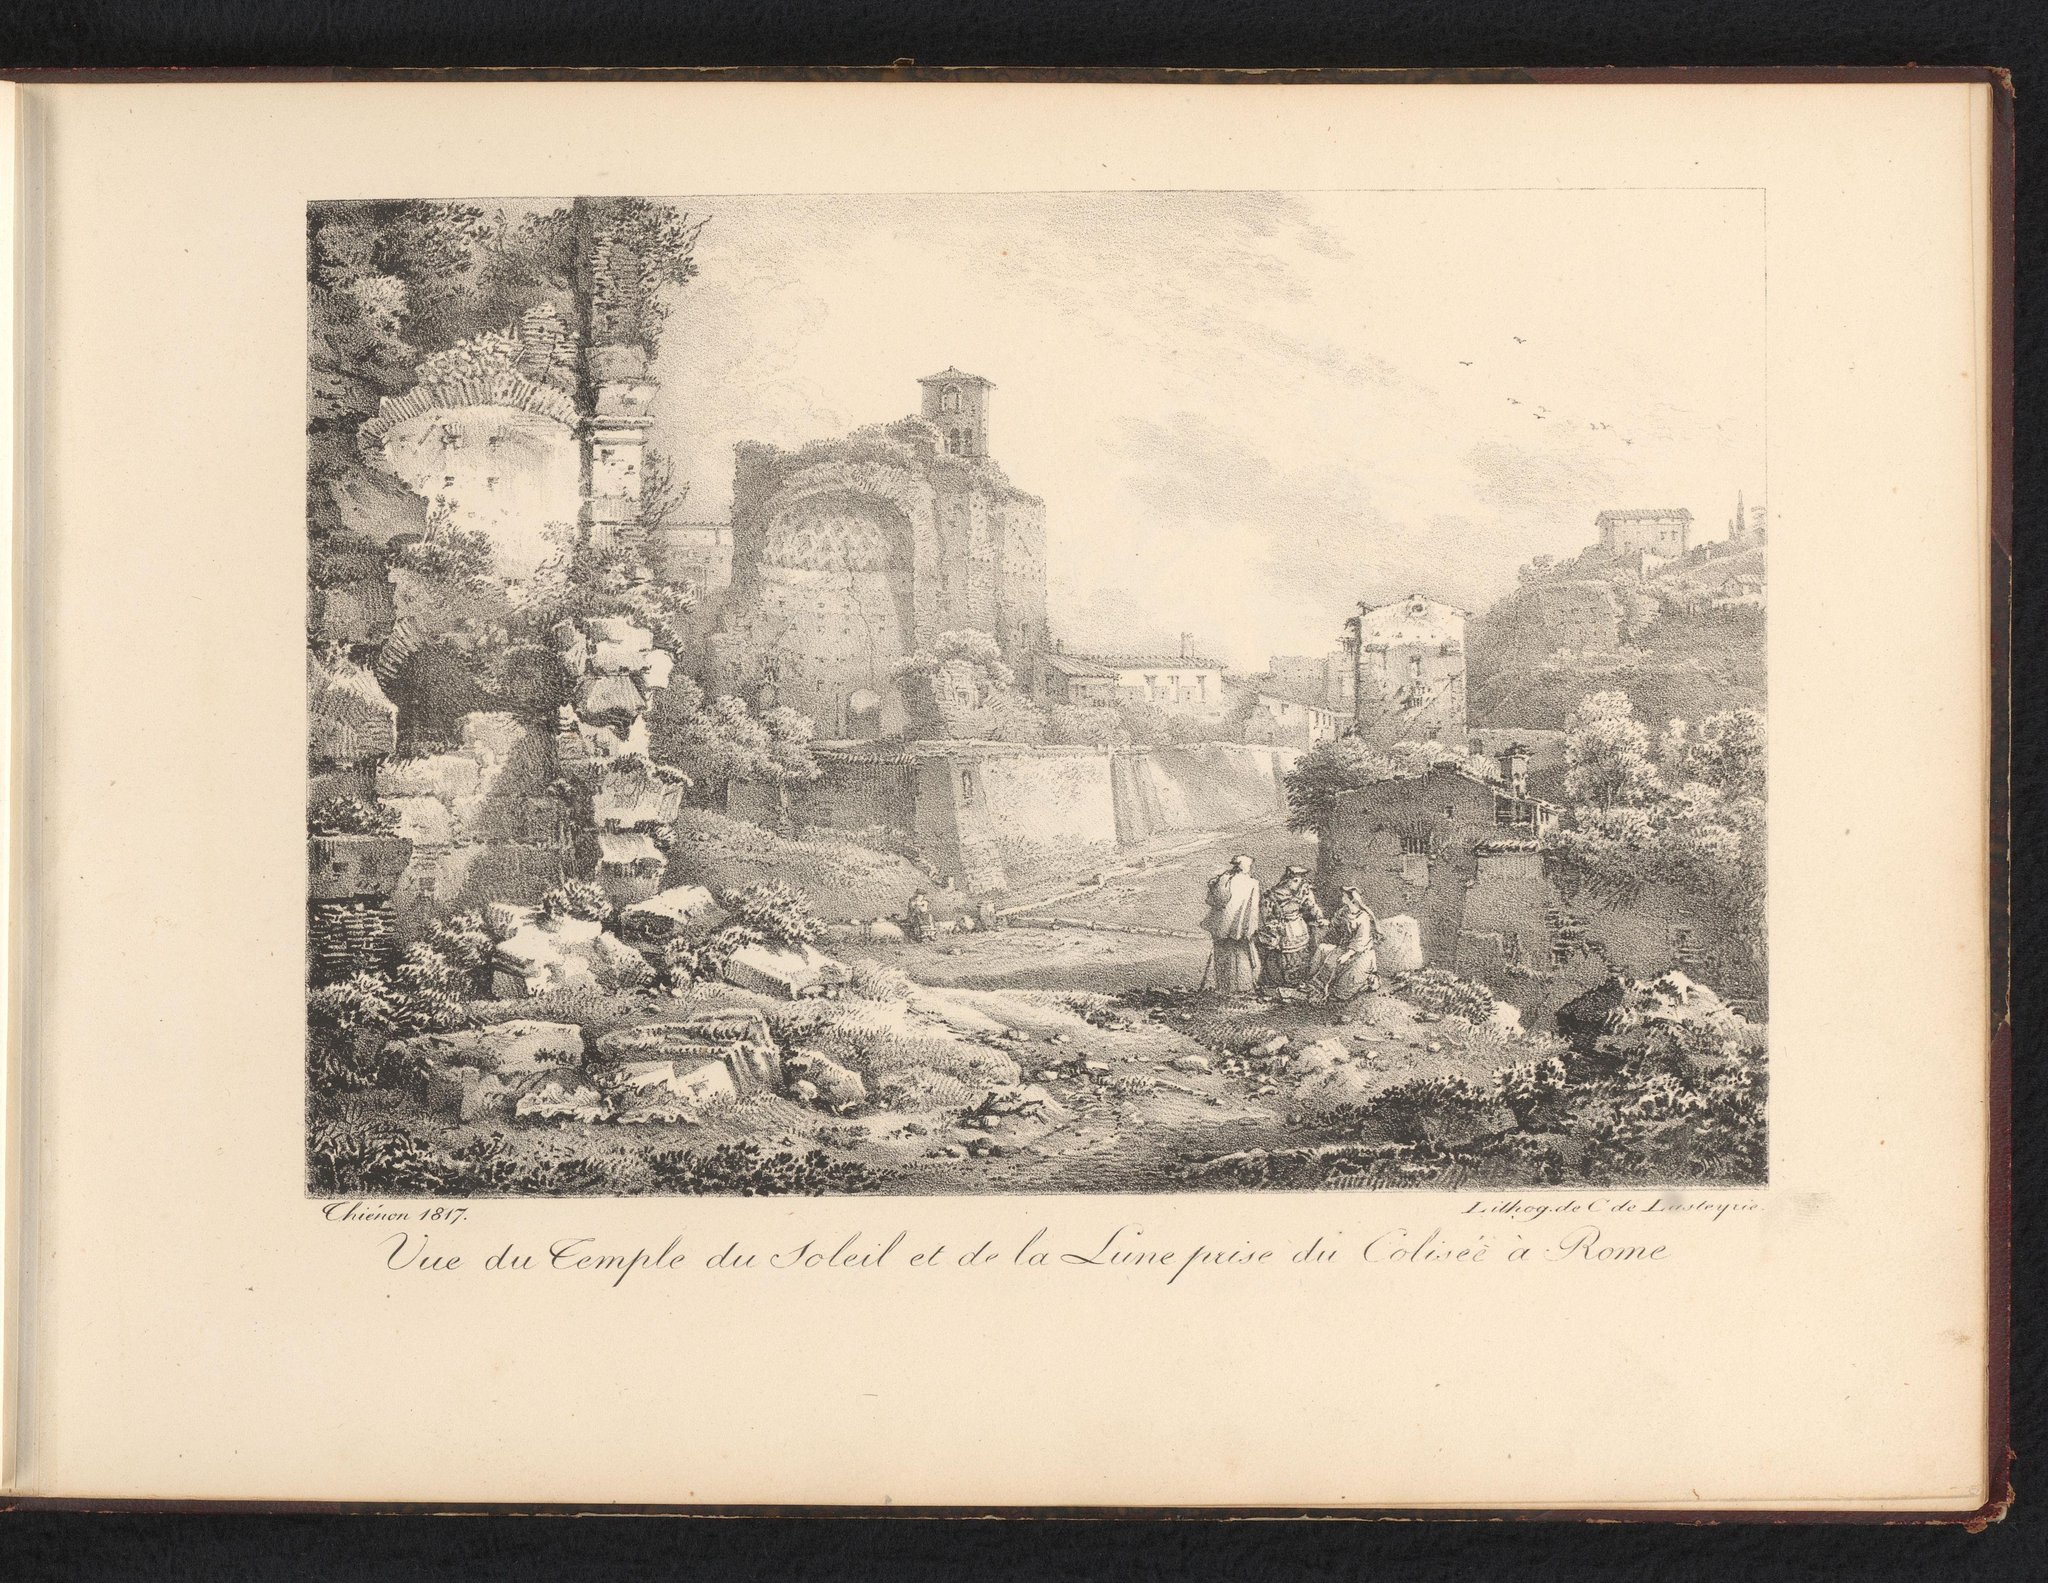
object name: print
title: Vue du Temple du Soleil et de la Lune prise du Colisée à Rome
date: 1817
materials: paper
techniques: lithograph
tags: landscape with ruins, rome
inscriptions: collector's mark: Lugt 2228, collector's mark: Lugt 2760